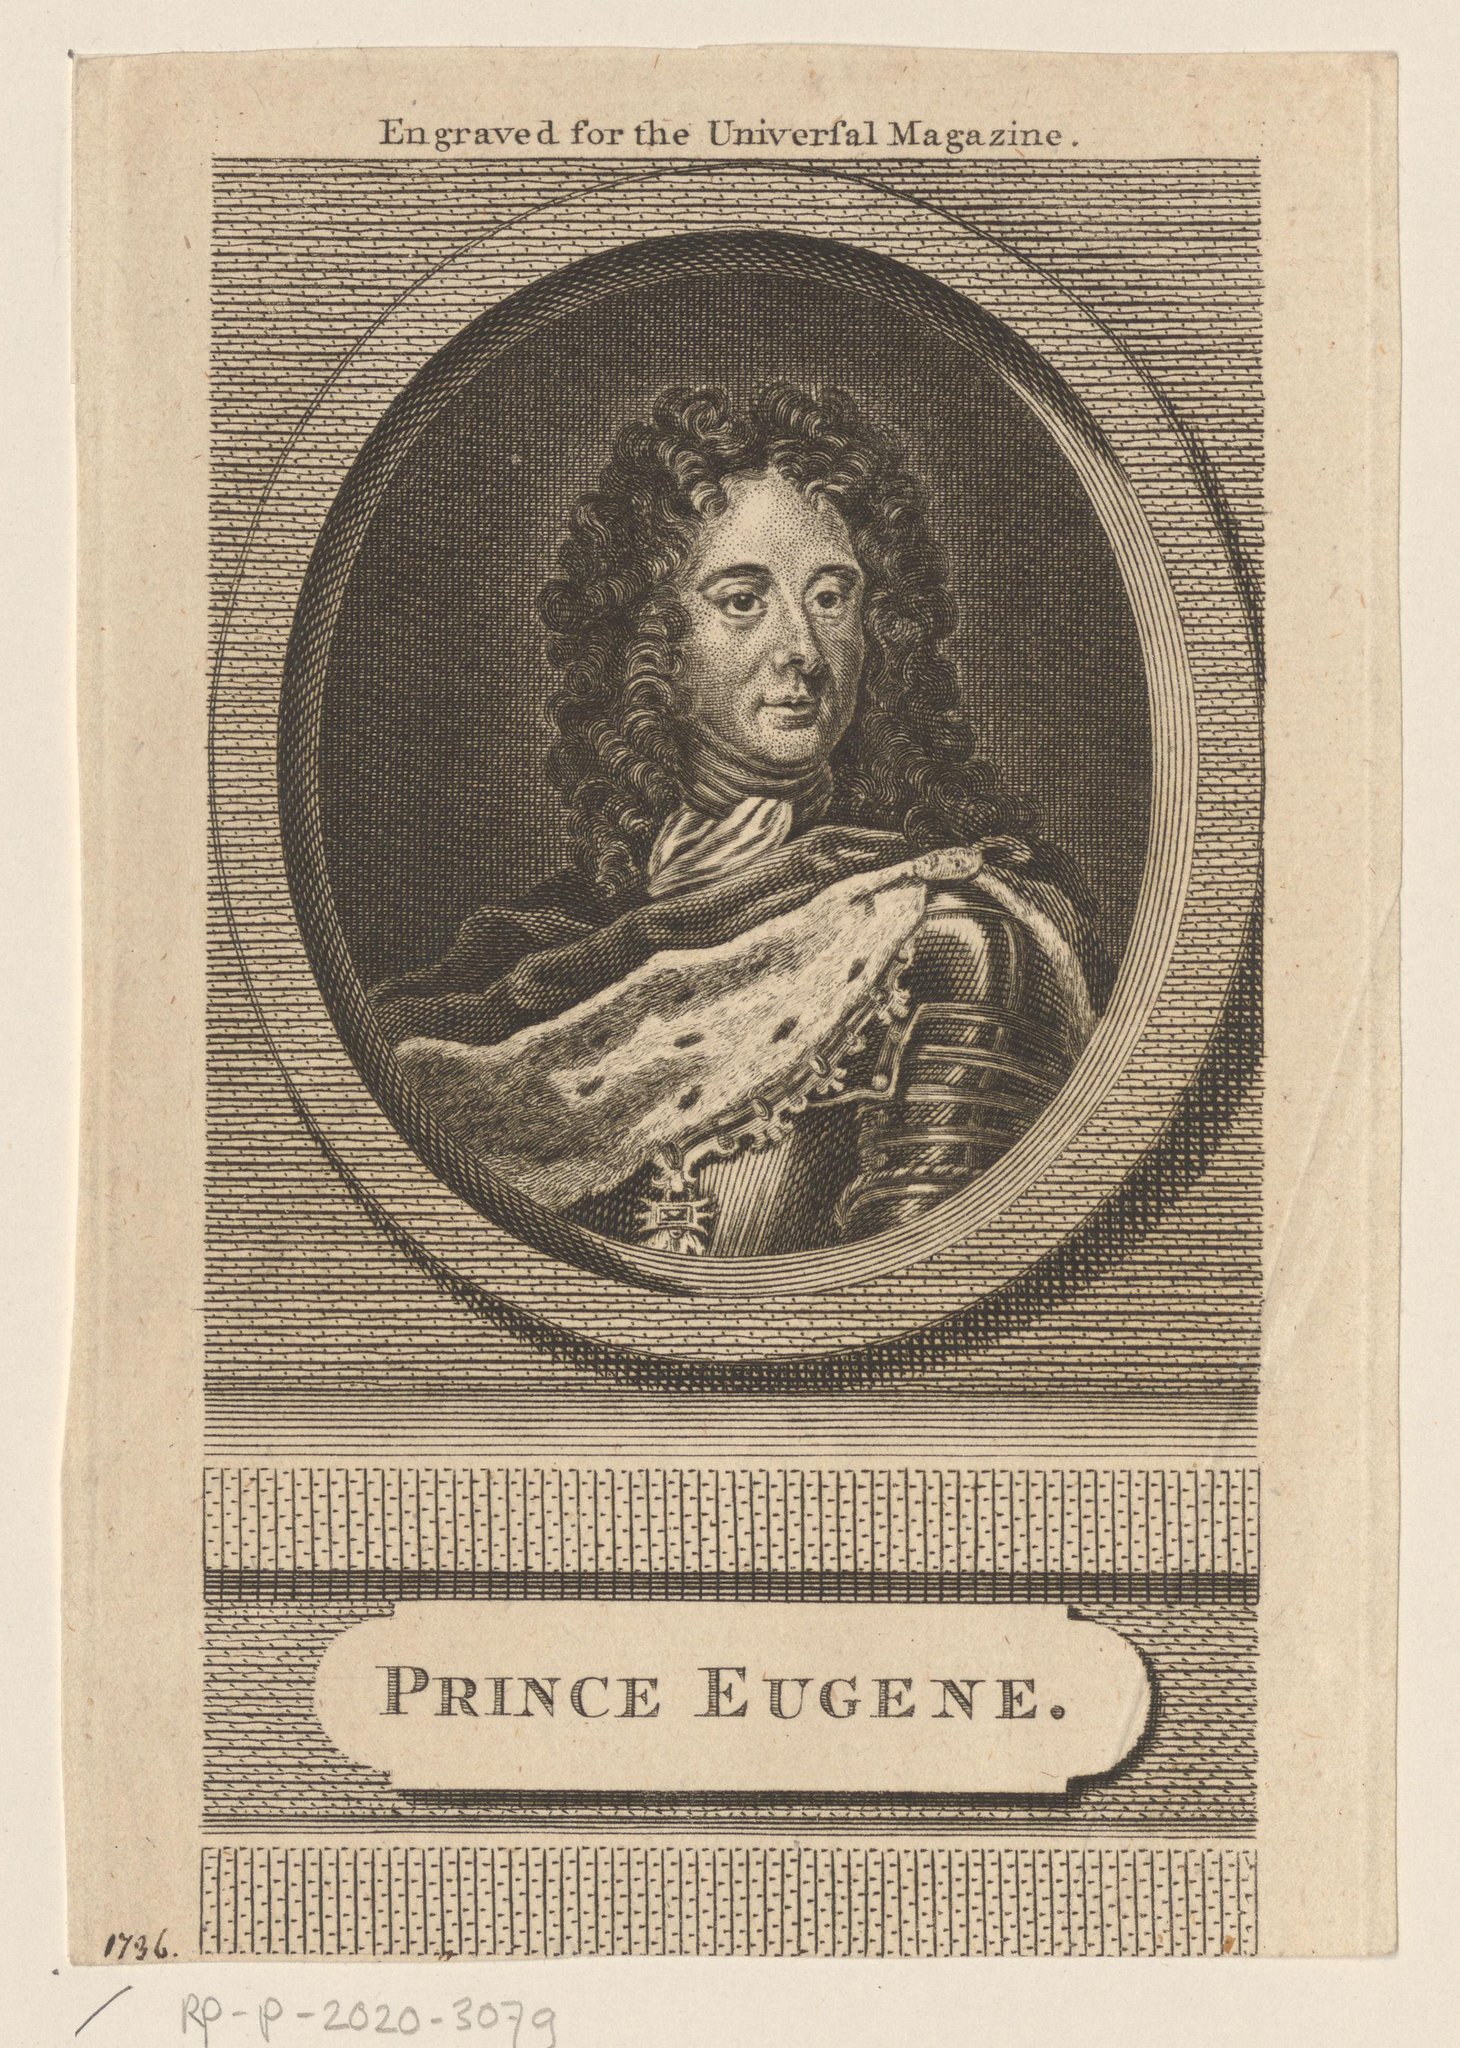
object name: print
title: Portret van Eugenius van Savoye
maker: Anonymous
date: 1747-1780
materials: paper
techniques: engraving, etching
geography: england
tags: paris, vienna, eugenius van savoye, historical persons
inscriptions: inscription: ‘1736’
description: Prent komt waarschijnlijk uit een uitgave van The Universal Magazine.